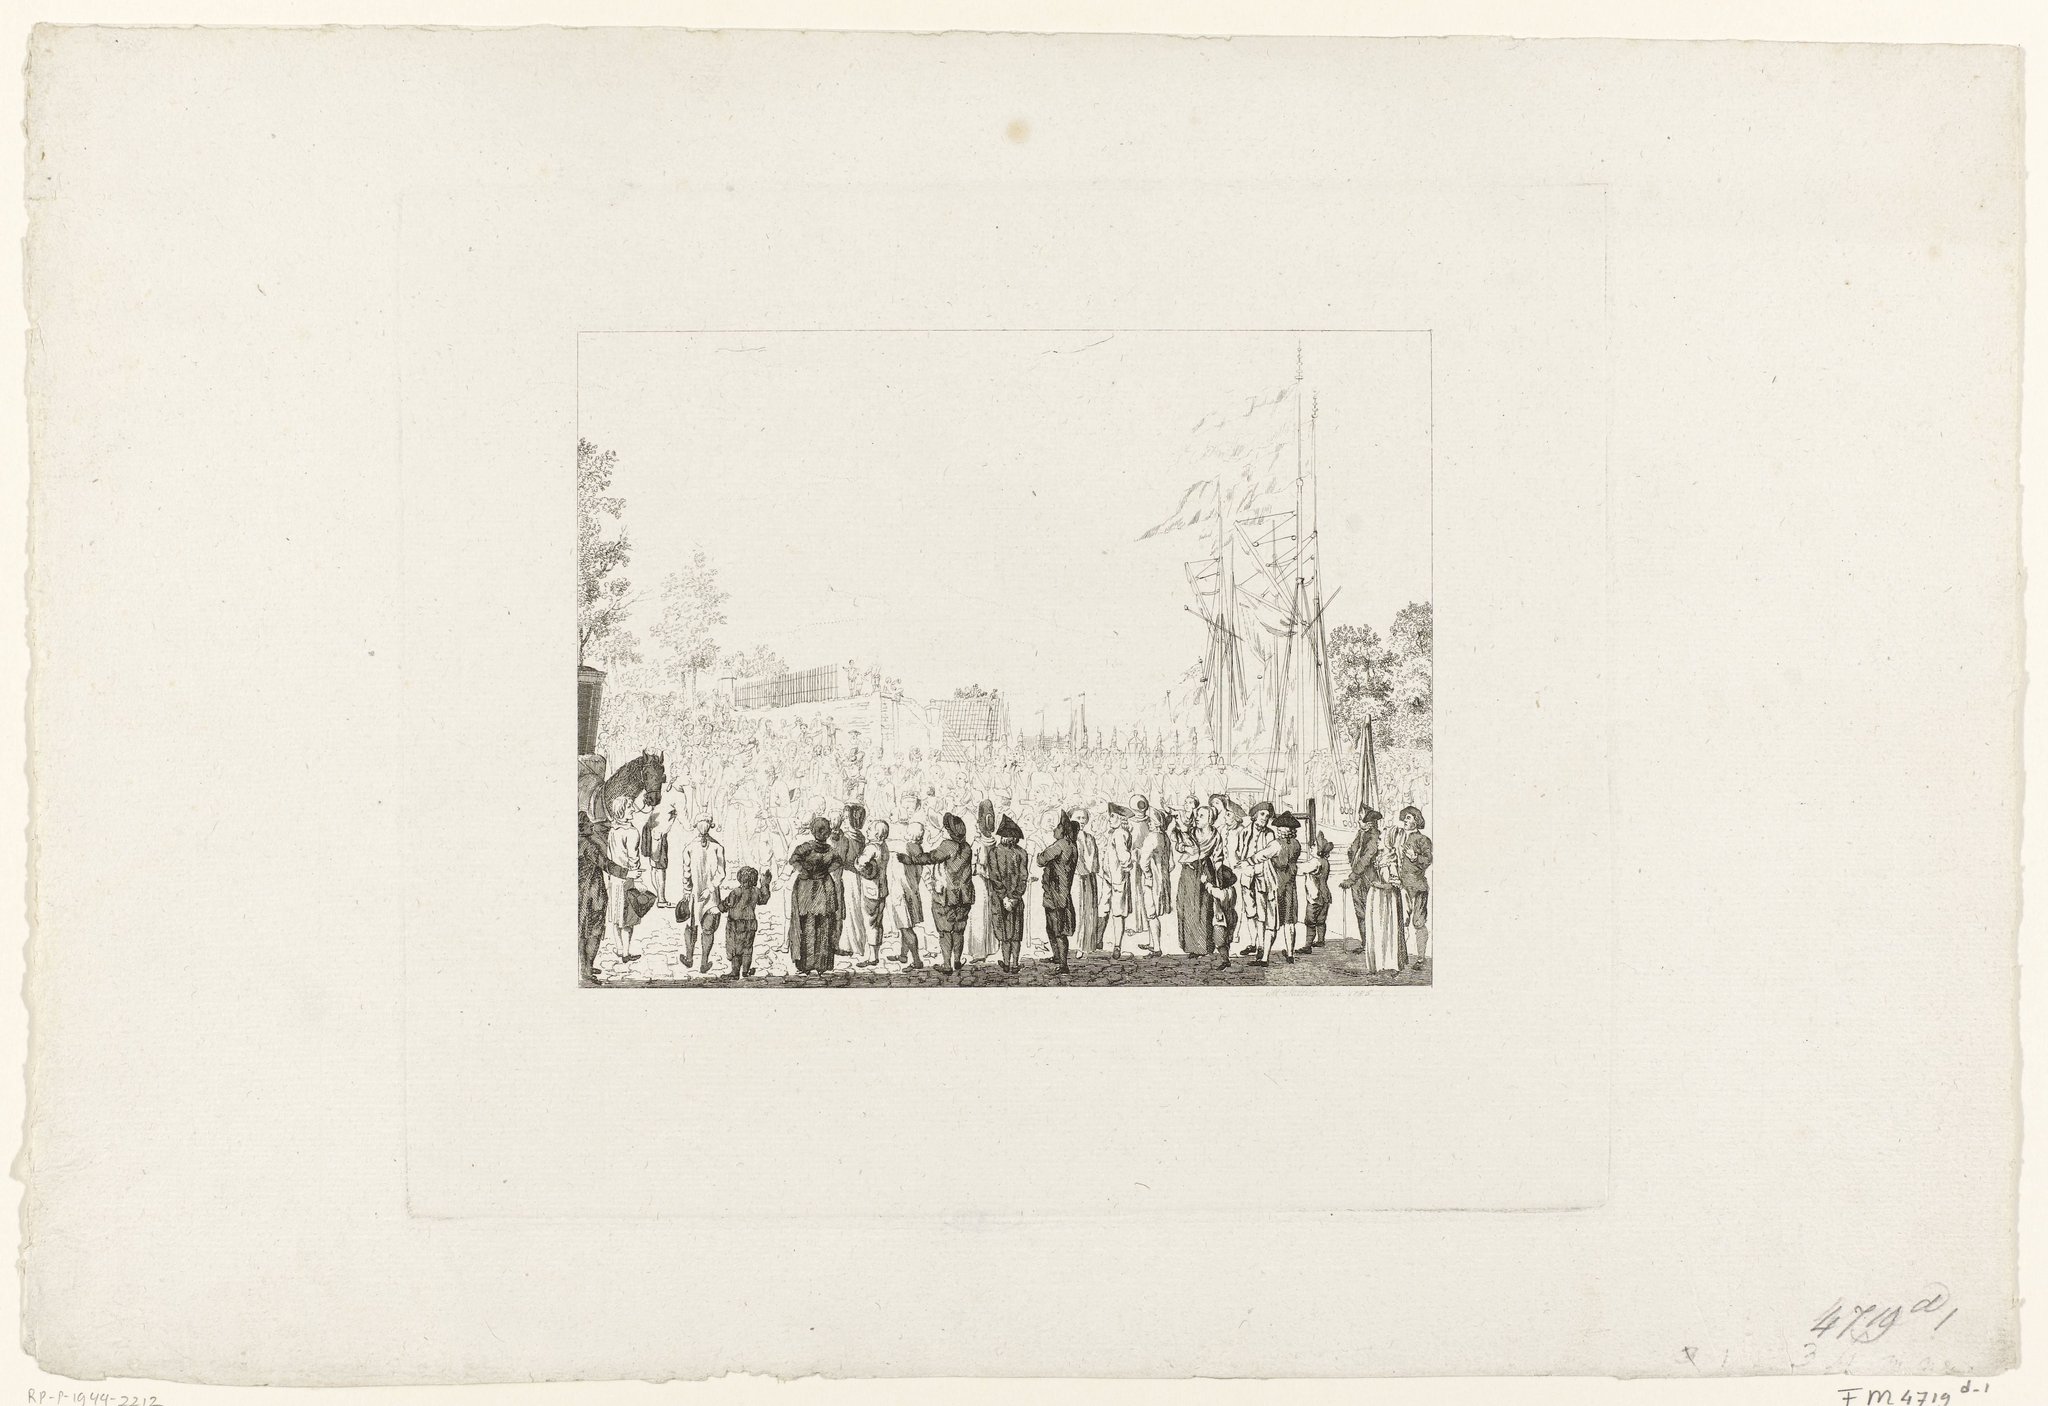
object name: print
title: Aankomst van de prins en prinses van Oranje te Middelburg, 1786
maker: mathias de sallieth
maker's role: print maker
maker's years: 1749-1791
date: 1786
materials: paper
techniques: etching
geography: northern netherlands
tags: the hague, william v (prince of orange), berlin, painter, draughtsman, wilhelmina of prussia (princess of orange), public festivities on the occasion of royal events, being welcomed ~ travelling, middelburg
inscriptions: collector's mark: Lugt 2228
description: Aankomst van prins Willem V en prinses Wilhelmina van Pruisen en hun kinderen te Middelburg op 18 juni 1786. Illustraties van het bezoek van de prins en prinses aan Zeeland 18 juni - 25 juli 1786.